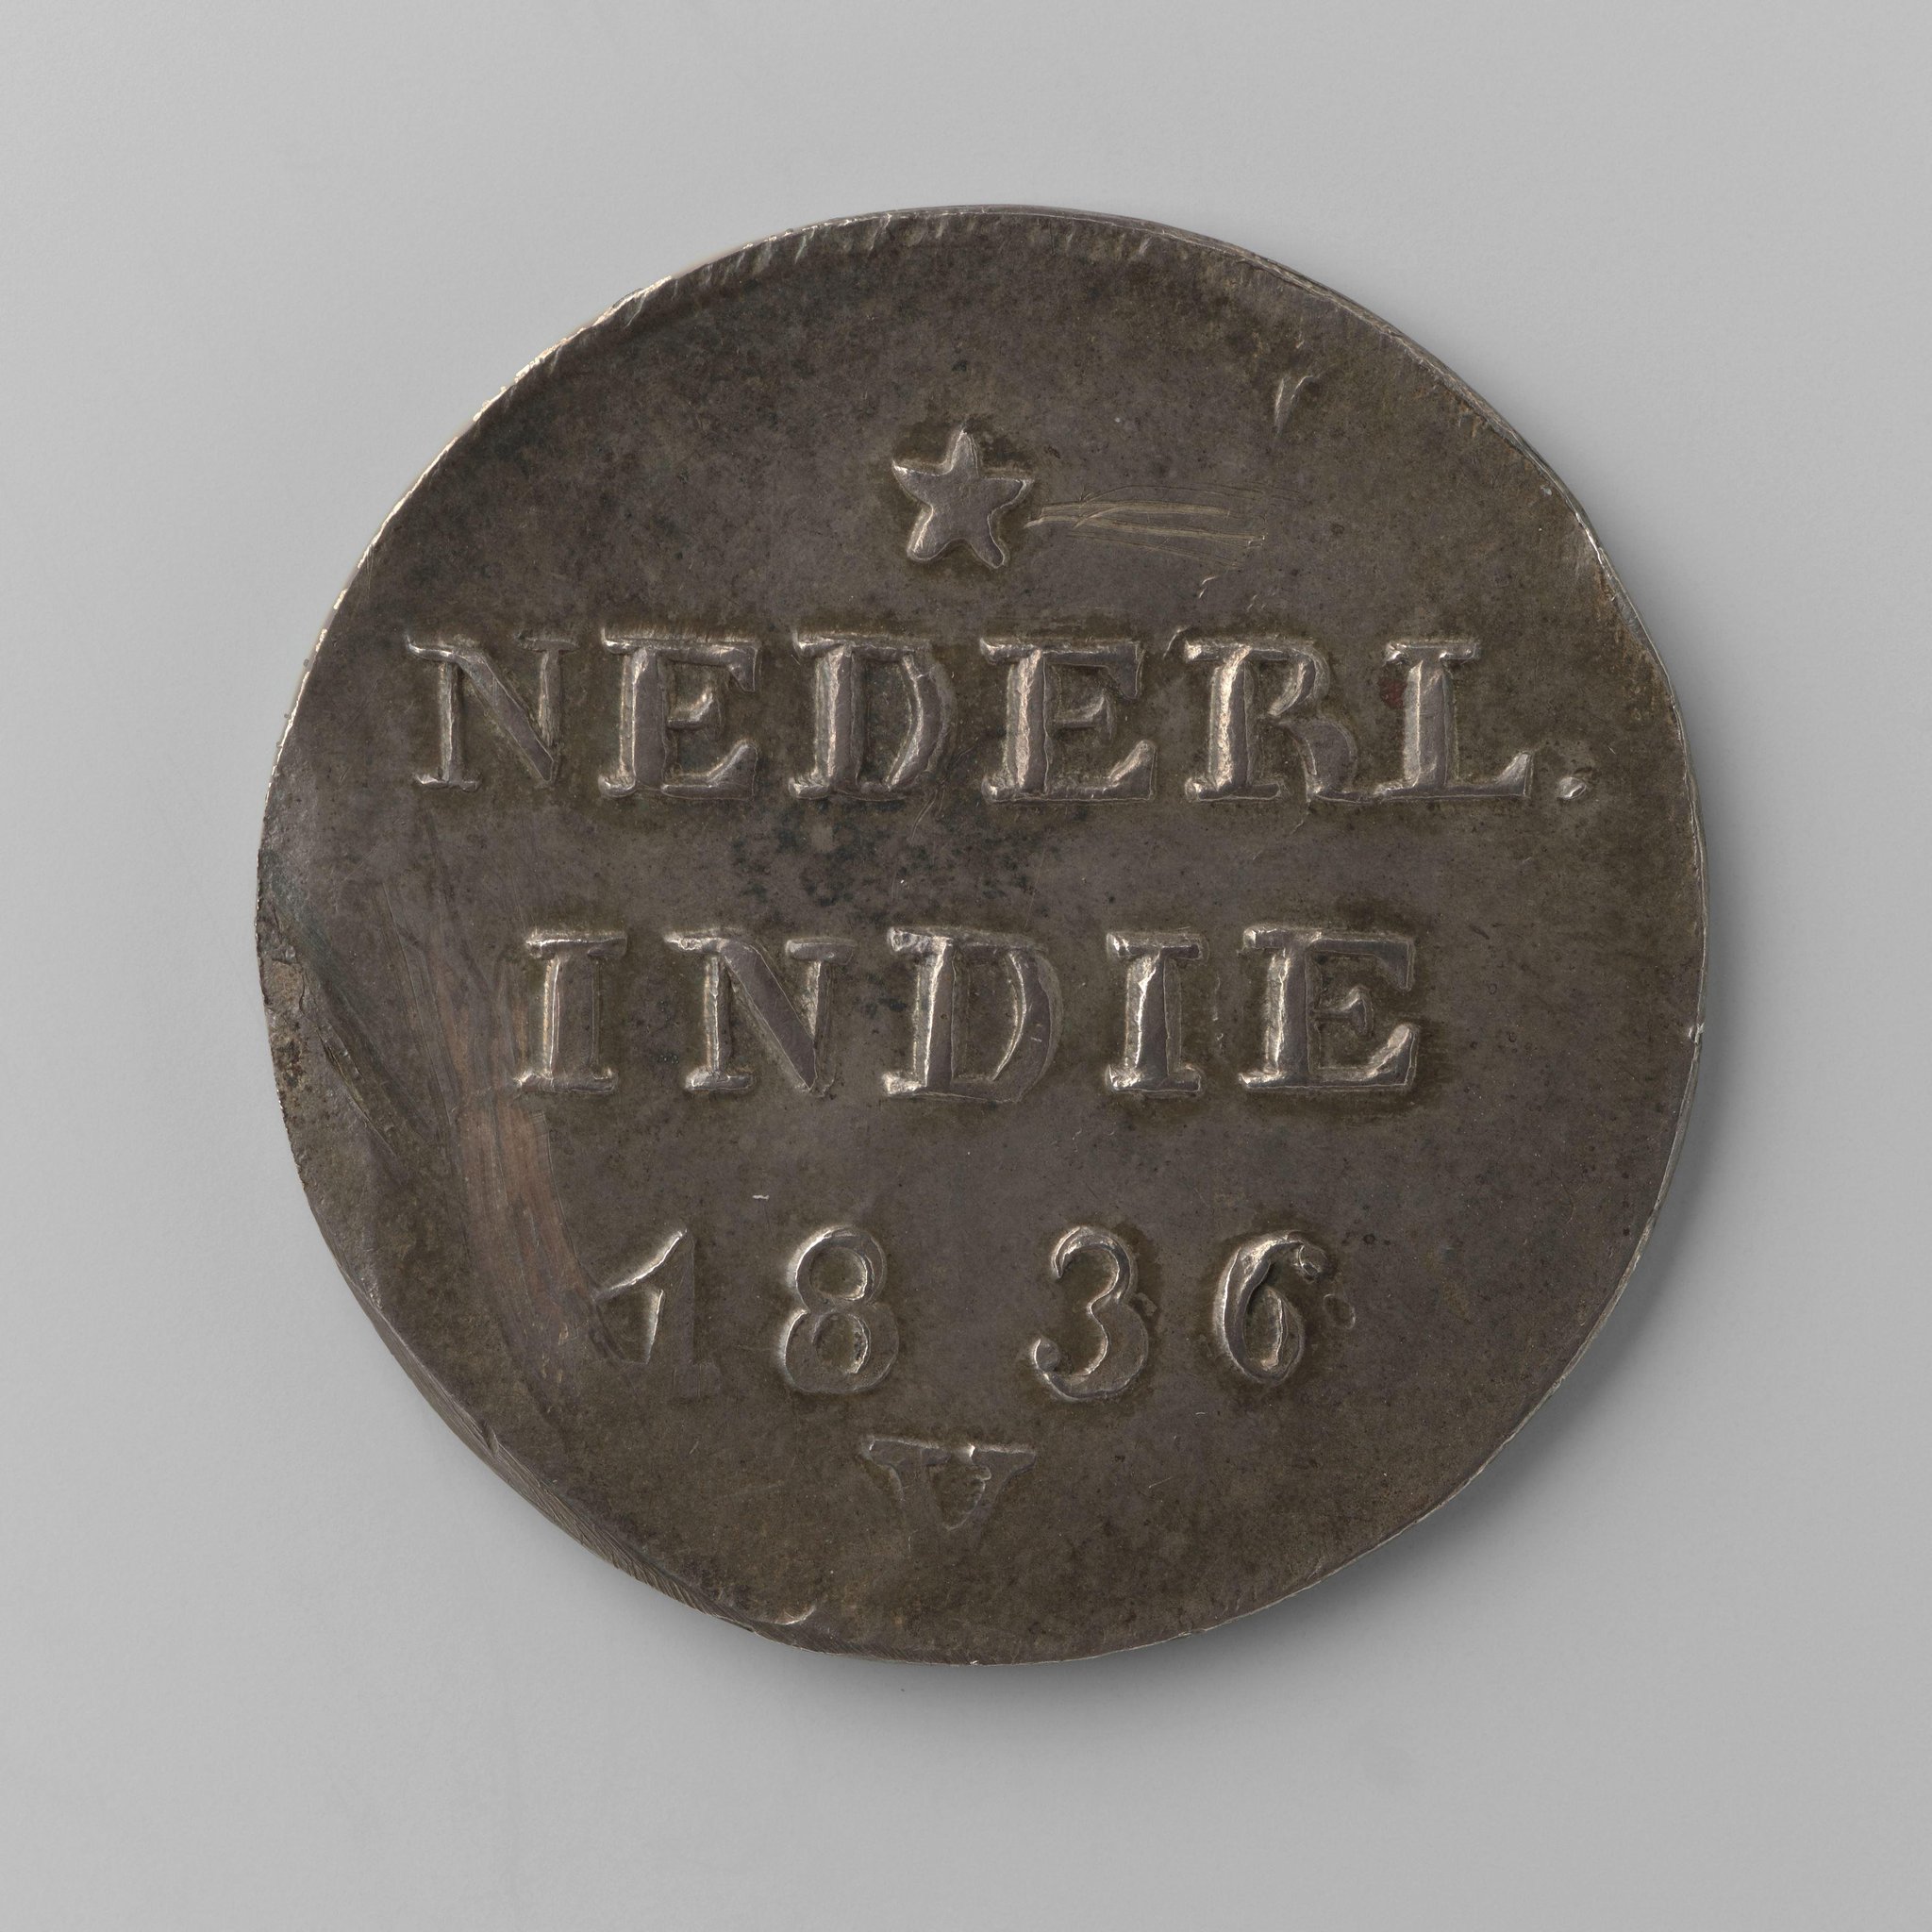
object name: coin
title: Nederlands Indië, 2 cent,1836 V. Zilveren afslag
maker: william i of the netherlands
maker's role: koning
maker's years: 1772-1843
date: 1836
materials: silver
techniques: striking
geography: surabaya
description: Zilveren munt. Voorzijde: tussen waarde-aanduiding 2 CT. gekroond rijkswapenschild. Keerzijde: tweeregelig opschrift, waarboven muntteken en waaronder jaartal. Daaronder letter V [=muntmeester De Vogel]. Gladde rand.